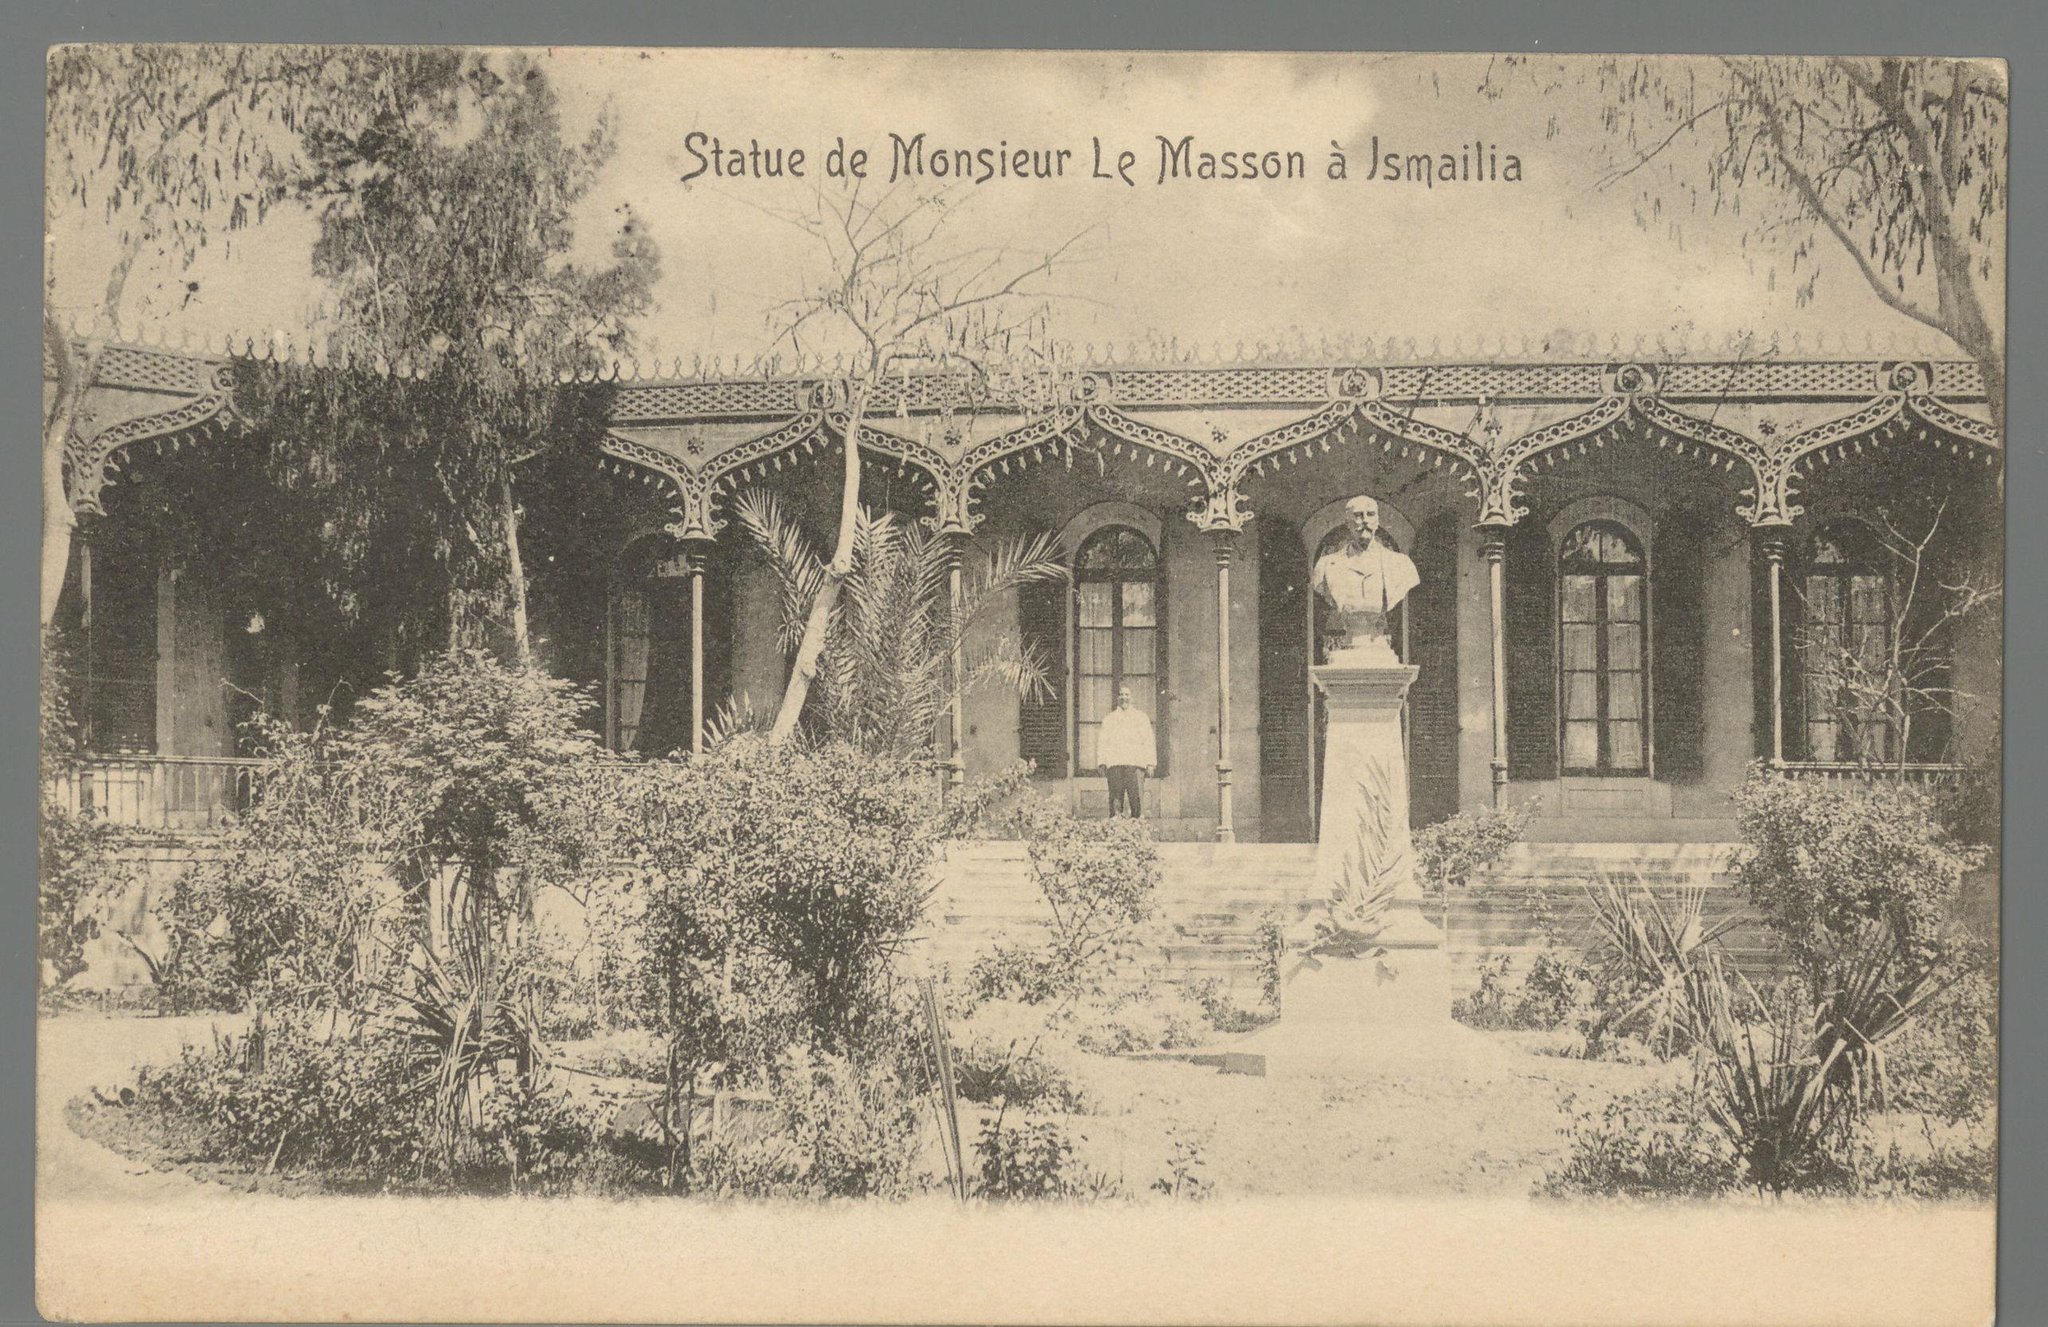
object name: photomechanical print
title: Statue de Monsieur Le Masson à Ismailia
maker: Anonymous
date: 1900-1903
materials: cardboard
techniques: photograph, writing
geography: ismailia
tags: garden, monument, statue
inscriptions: poststempel, verso, gestempeld